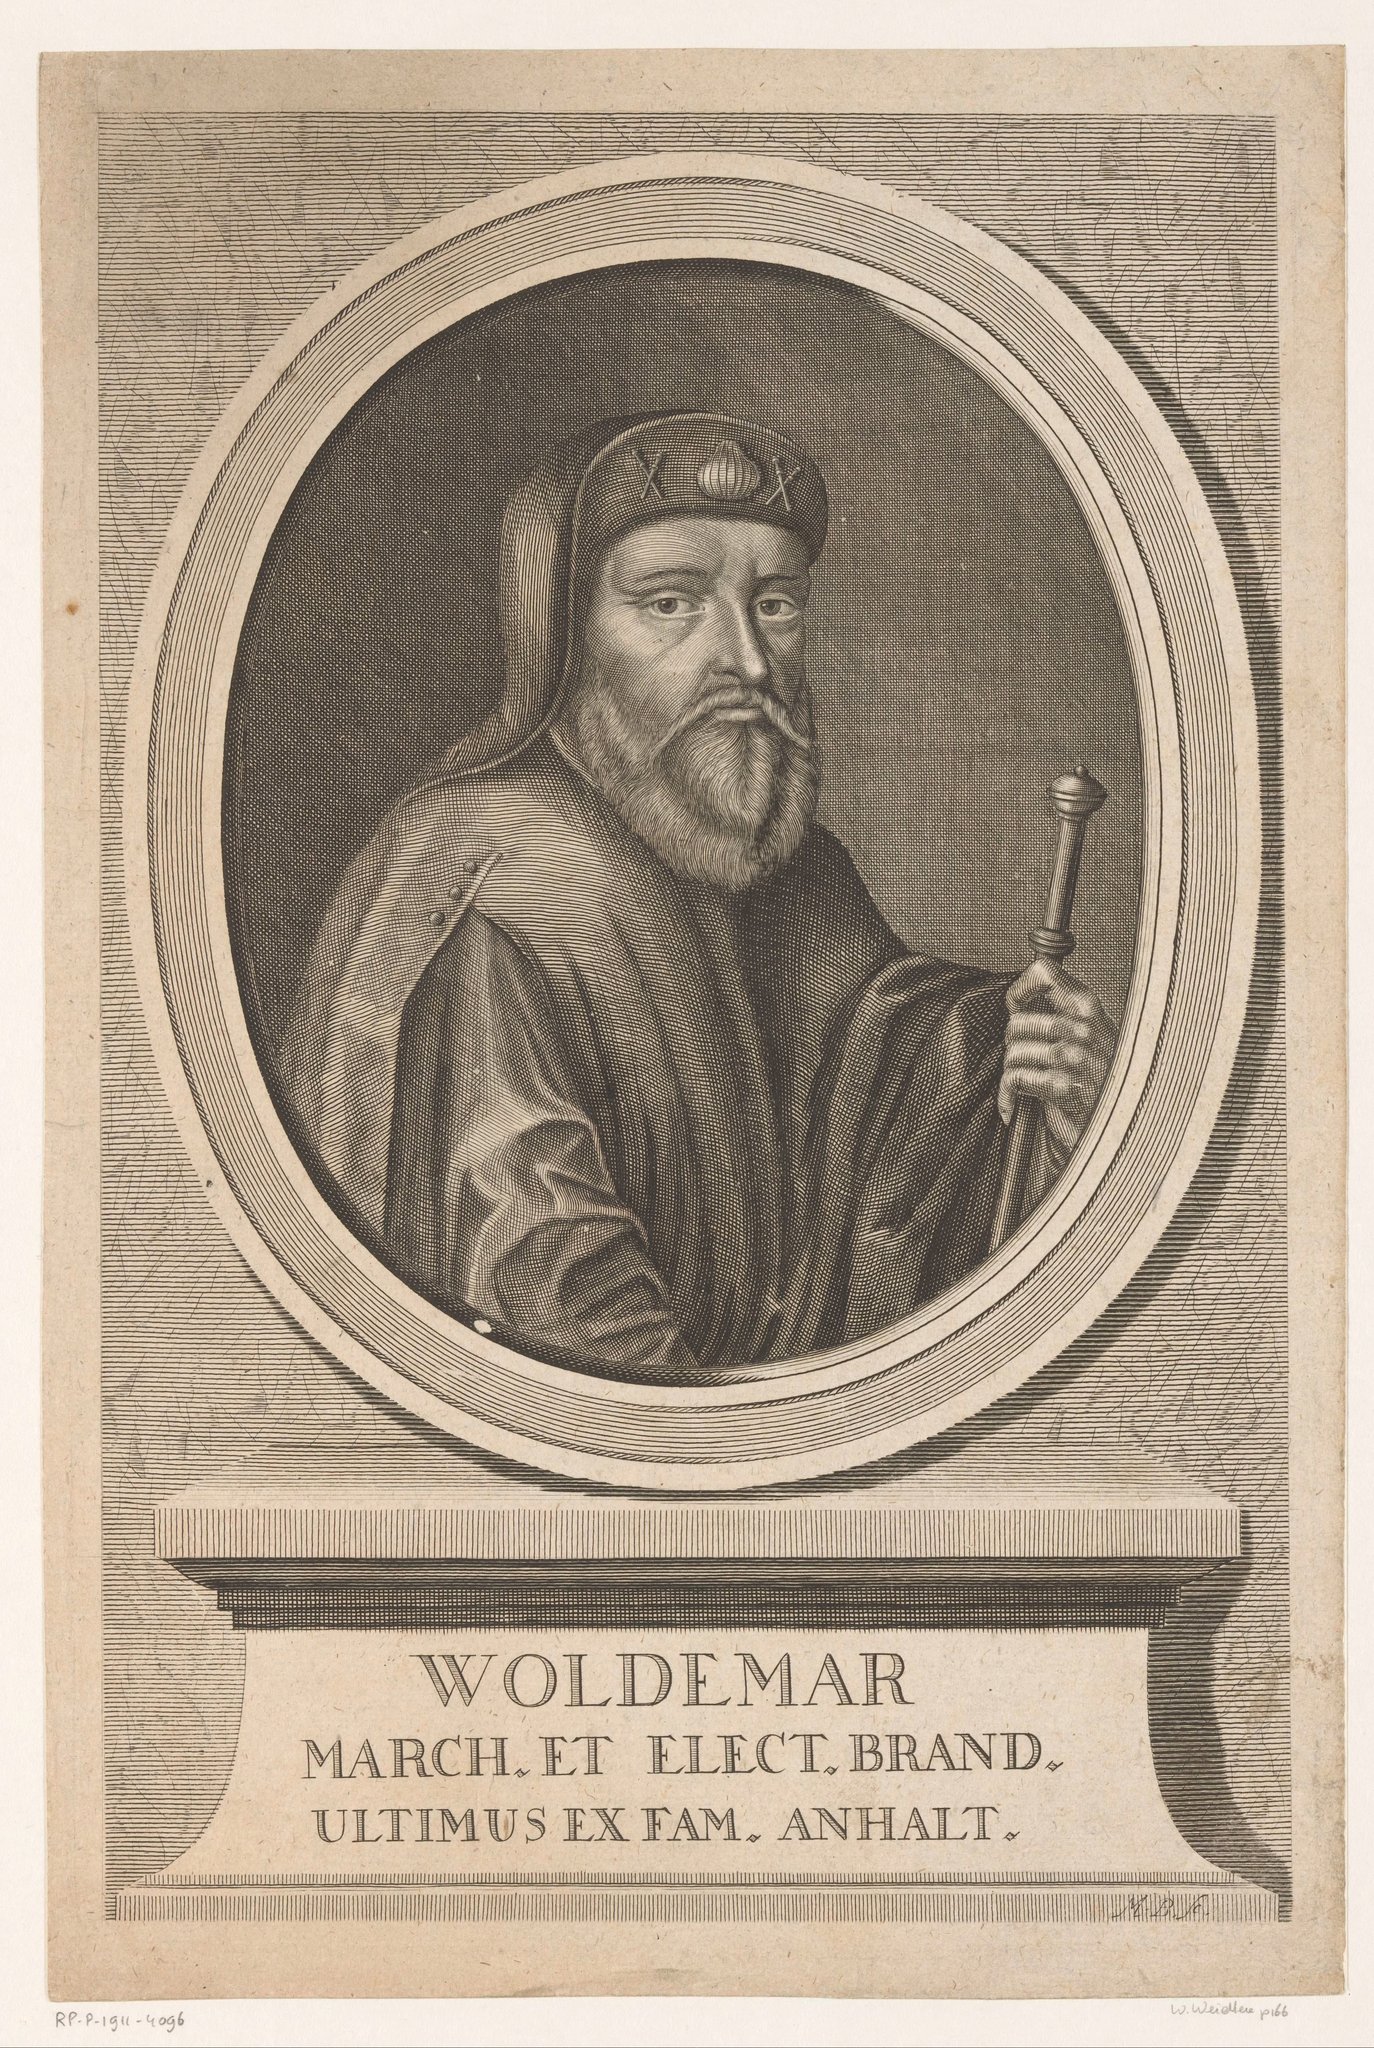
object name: print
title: Portret van Waldemar, markgraaf van Brandenburg, gekleed als pelgrim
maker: martin bernigeroth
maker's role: print maker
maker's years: 1670-1733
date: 1680-1733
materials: paper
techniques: engraving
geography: leipzig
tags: historical persons, pilgrim's dress and attributes, e.g. flask, hat, mantle, staff, (oyster) shell ~ attribute of pilgrim(s)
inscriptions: collector's mark: Lugt 2228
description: In 1348 meldde een oude man zich bij de aartsbisschop van Maagdenburg die claimde markgraaf Waldemar te zijn, teruggekeerd uit het Heilige Land. Hij werd in 1350 als bedrieger ontmaskerd. Mogelijk verwijst dit portret naar deze anekdote.